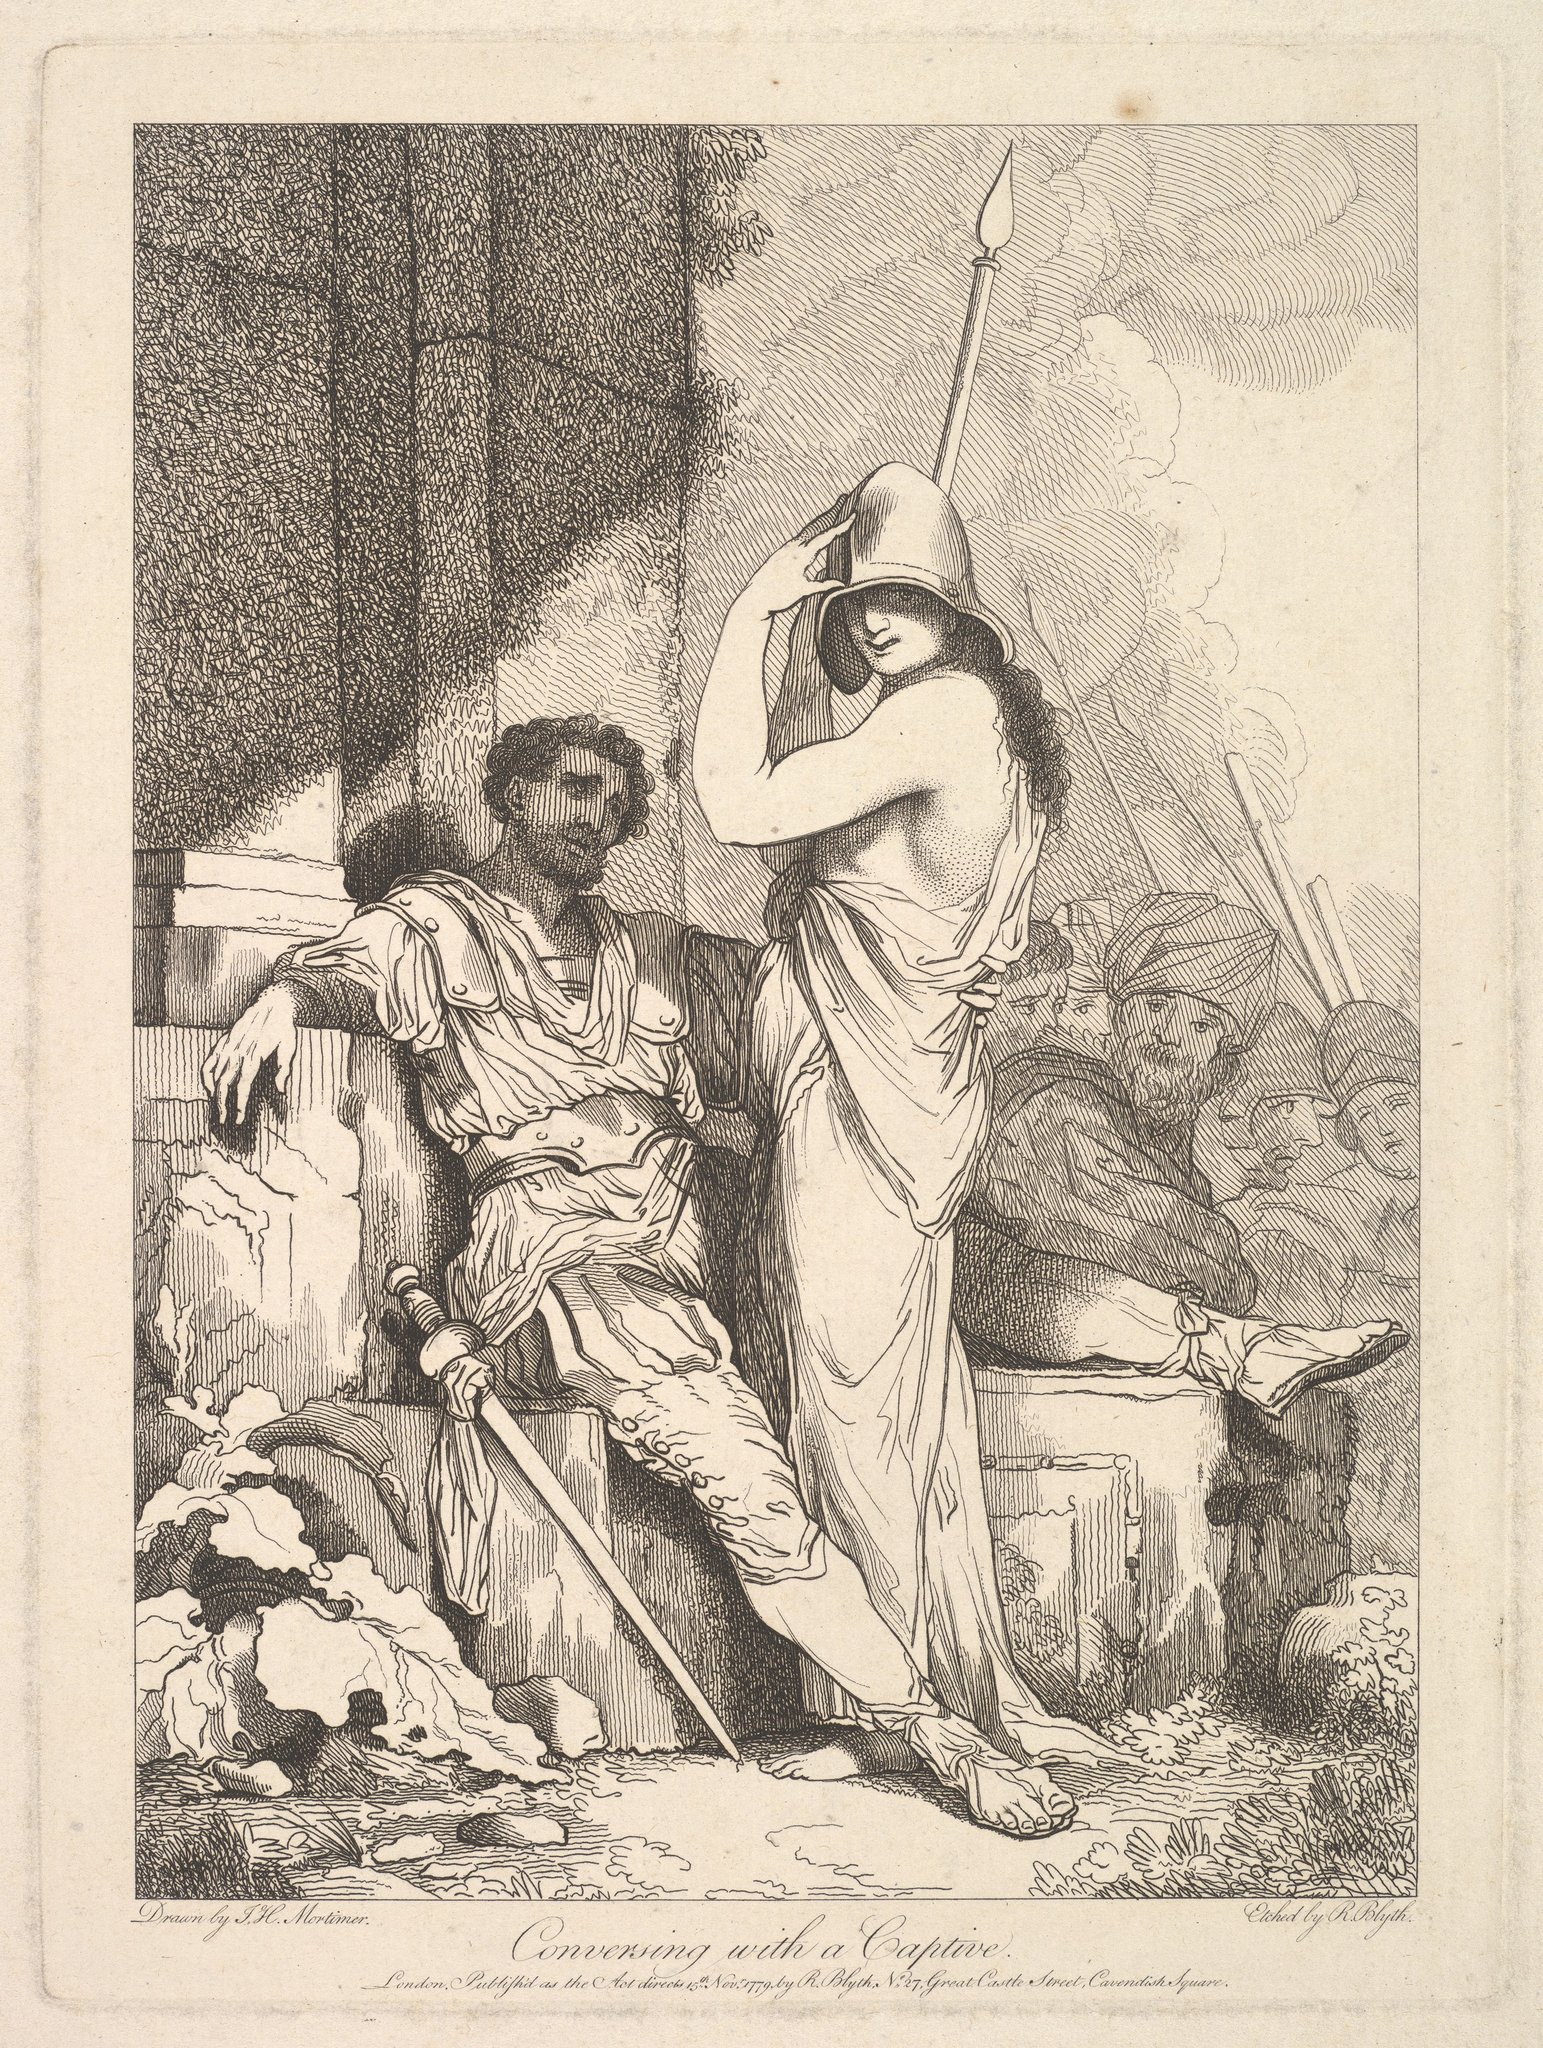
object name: print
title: Conversing with a Captive, from "Banditti Variously Employed"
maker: robert blyth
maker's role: artist and publisher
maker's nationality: british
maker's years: 1750-1784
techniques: etching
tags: prisoners,swords,men,women